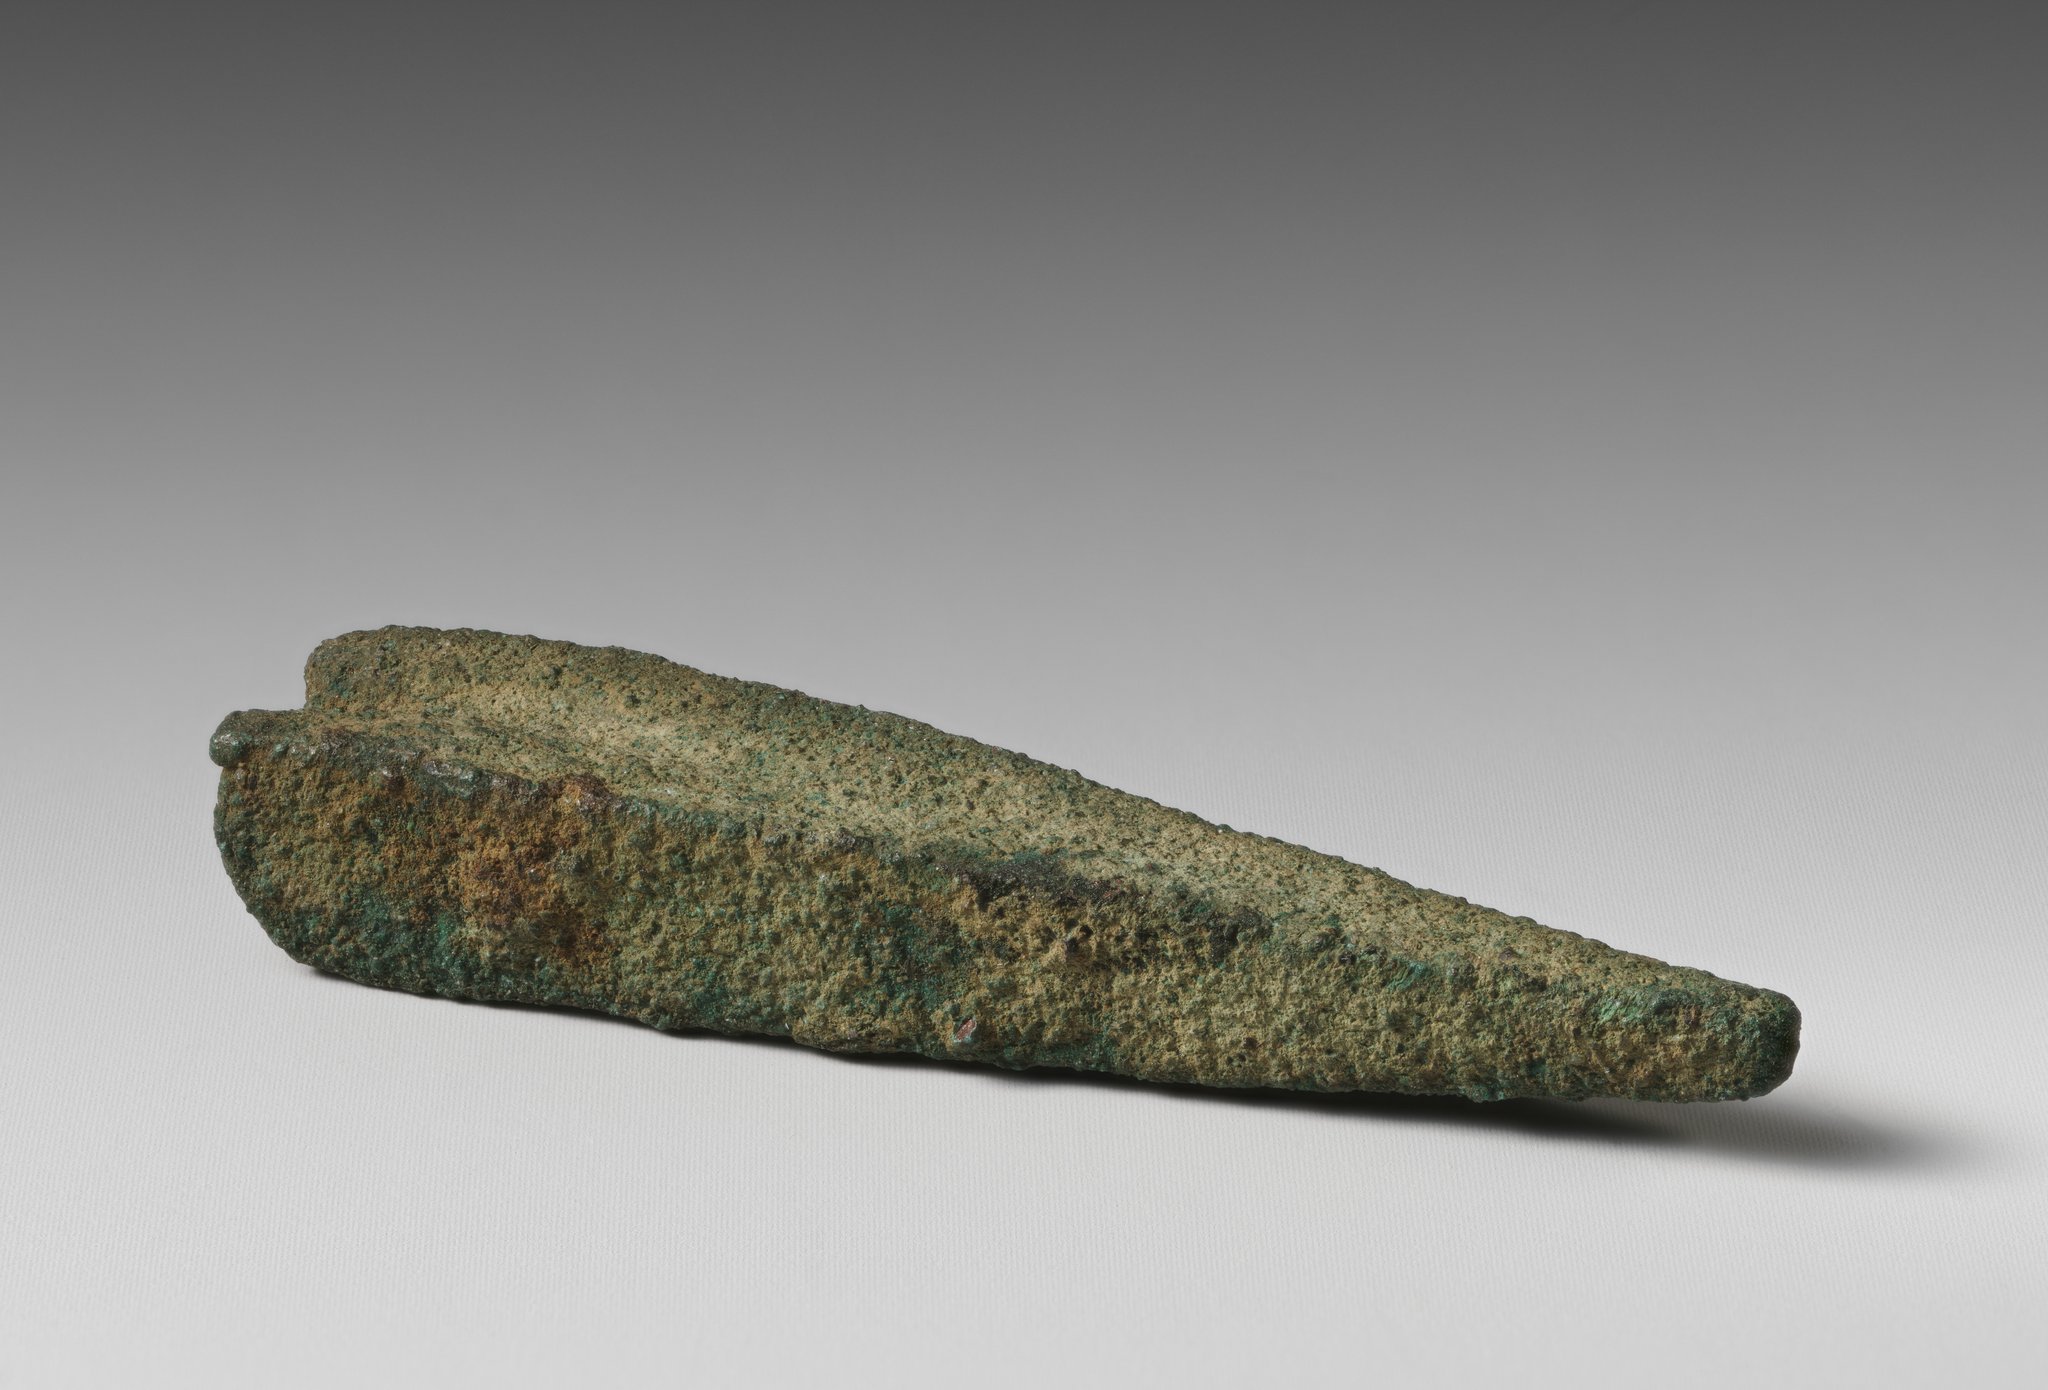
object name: nail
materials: bronze, copper alloy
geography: egypt